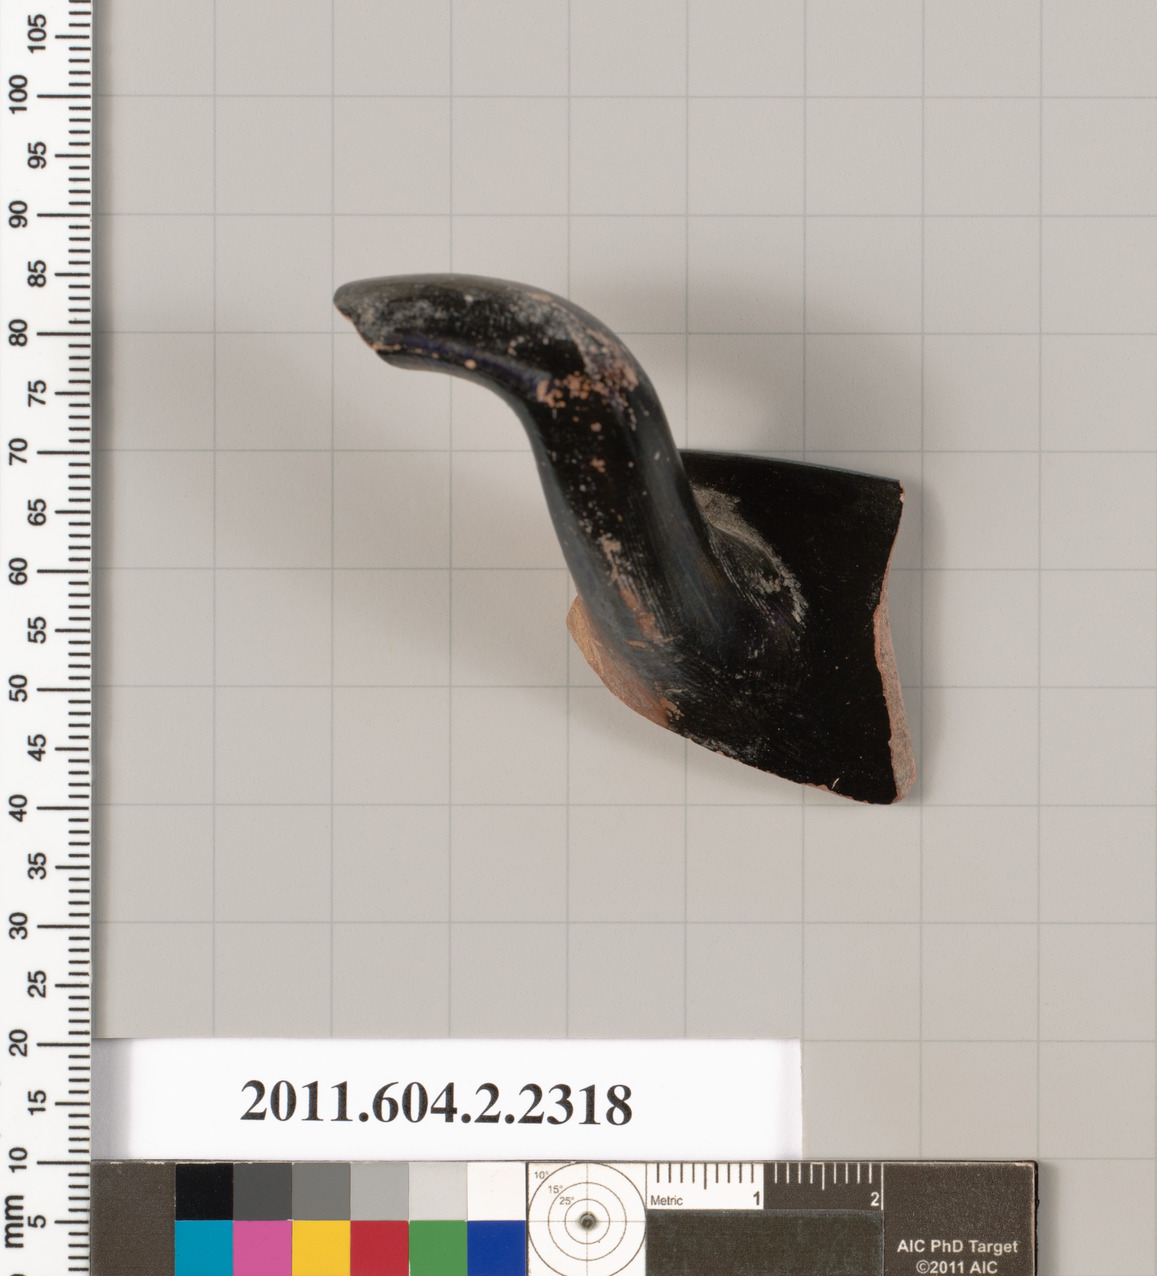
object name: skyphos fragment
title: Terracotta fragment of a skyphos (deep drinking cup)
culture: greek, attic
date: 600-401 BCE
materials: terracotta